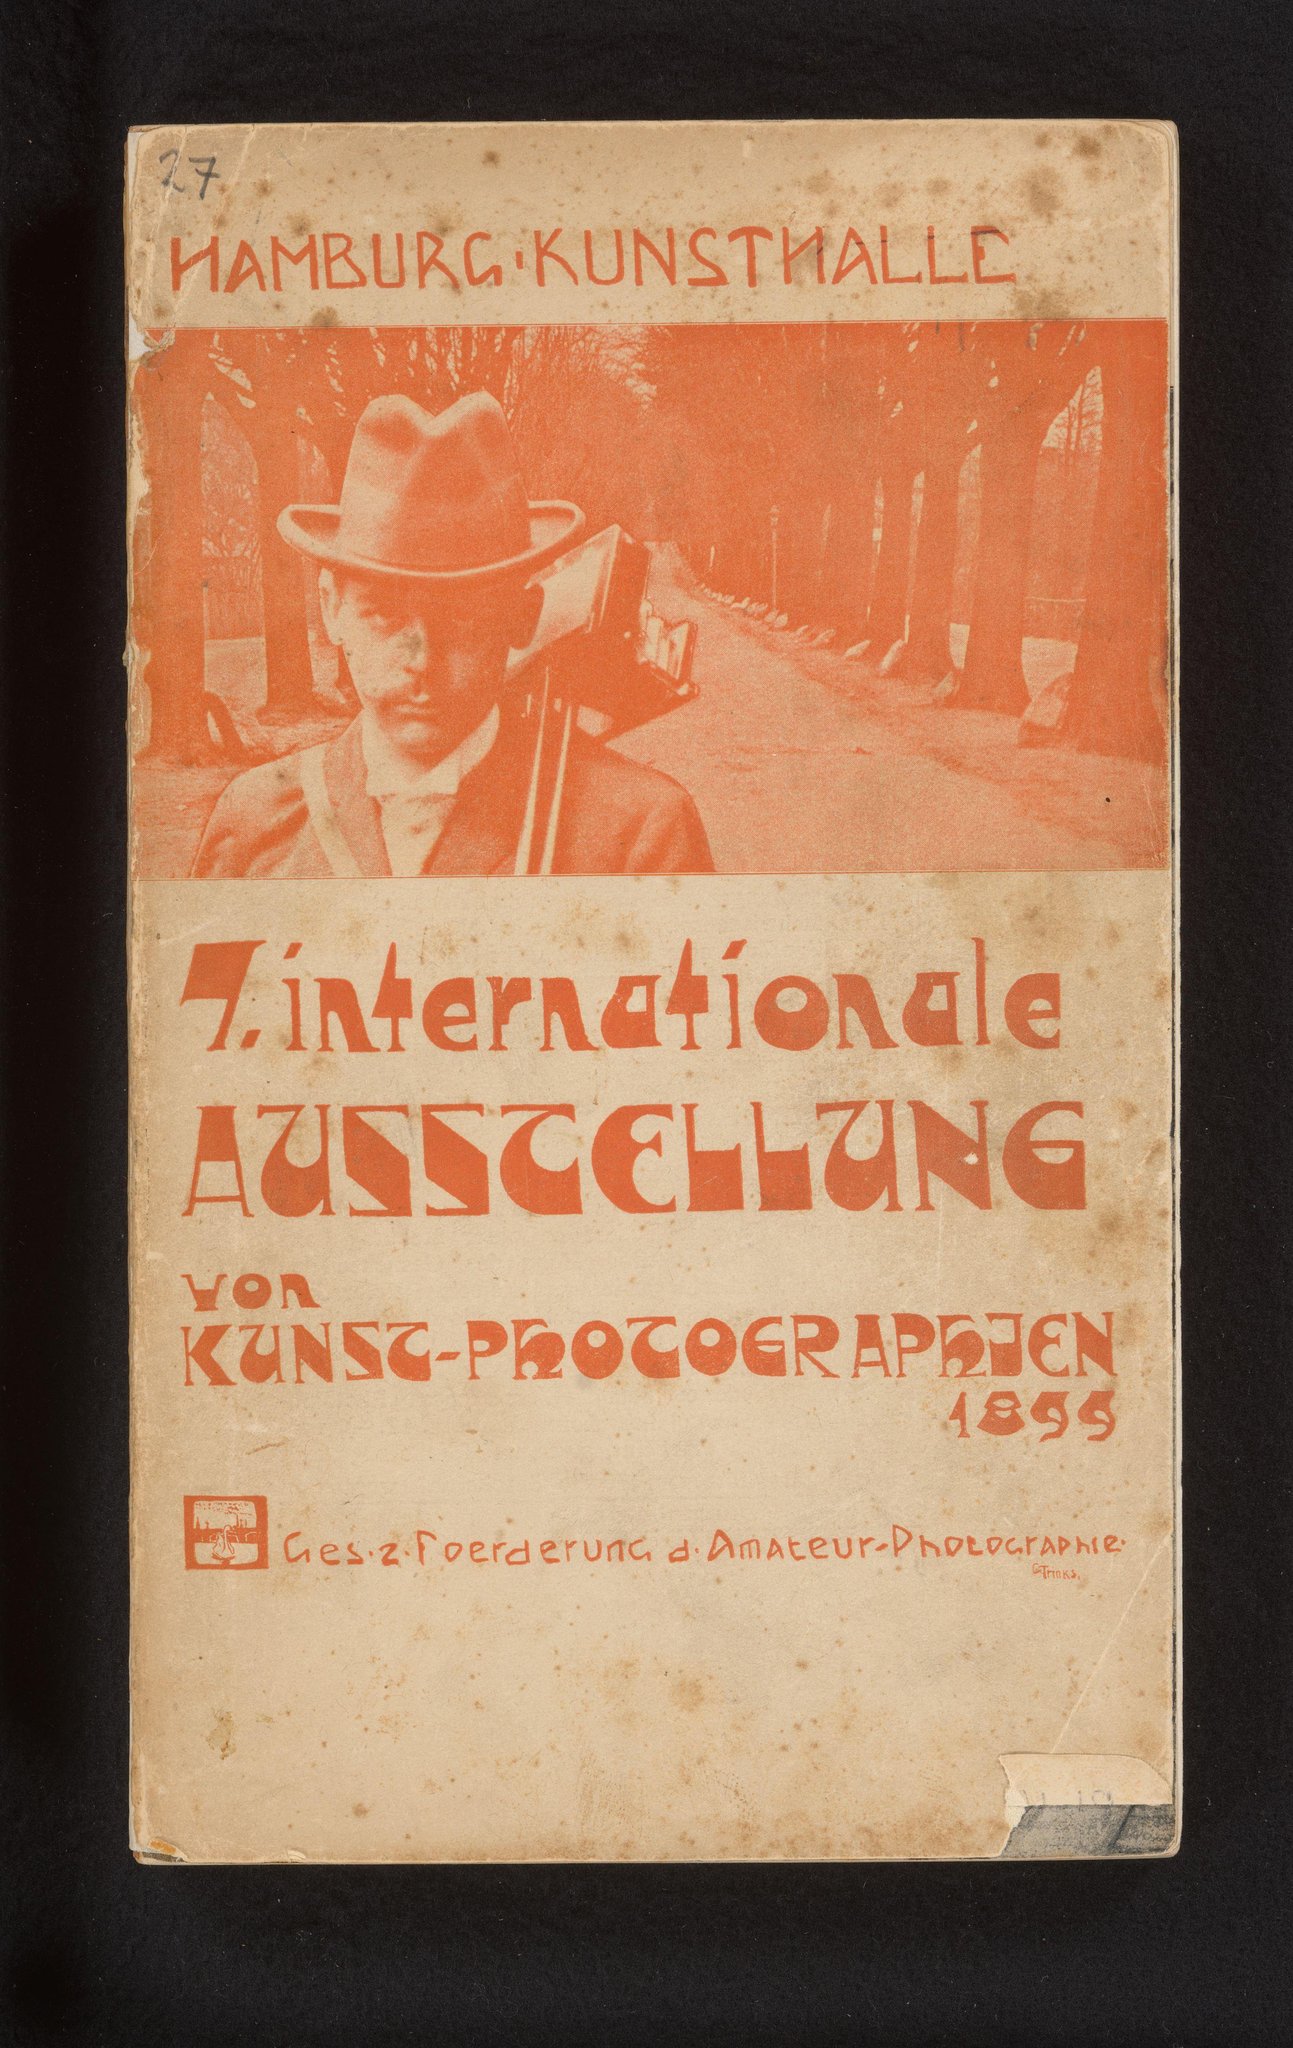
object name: book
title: 7. Internationale Ausstellung von Kunst-Photographien 1899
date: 1899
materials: paper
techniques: gelatin silver print, letterpress printing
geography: hamburg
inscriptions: number: ‘27.’